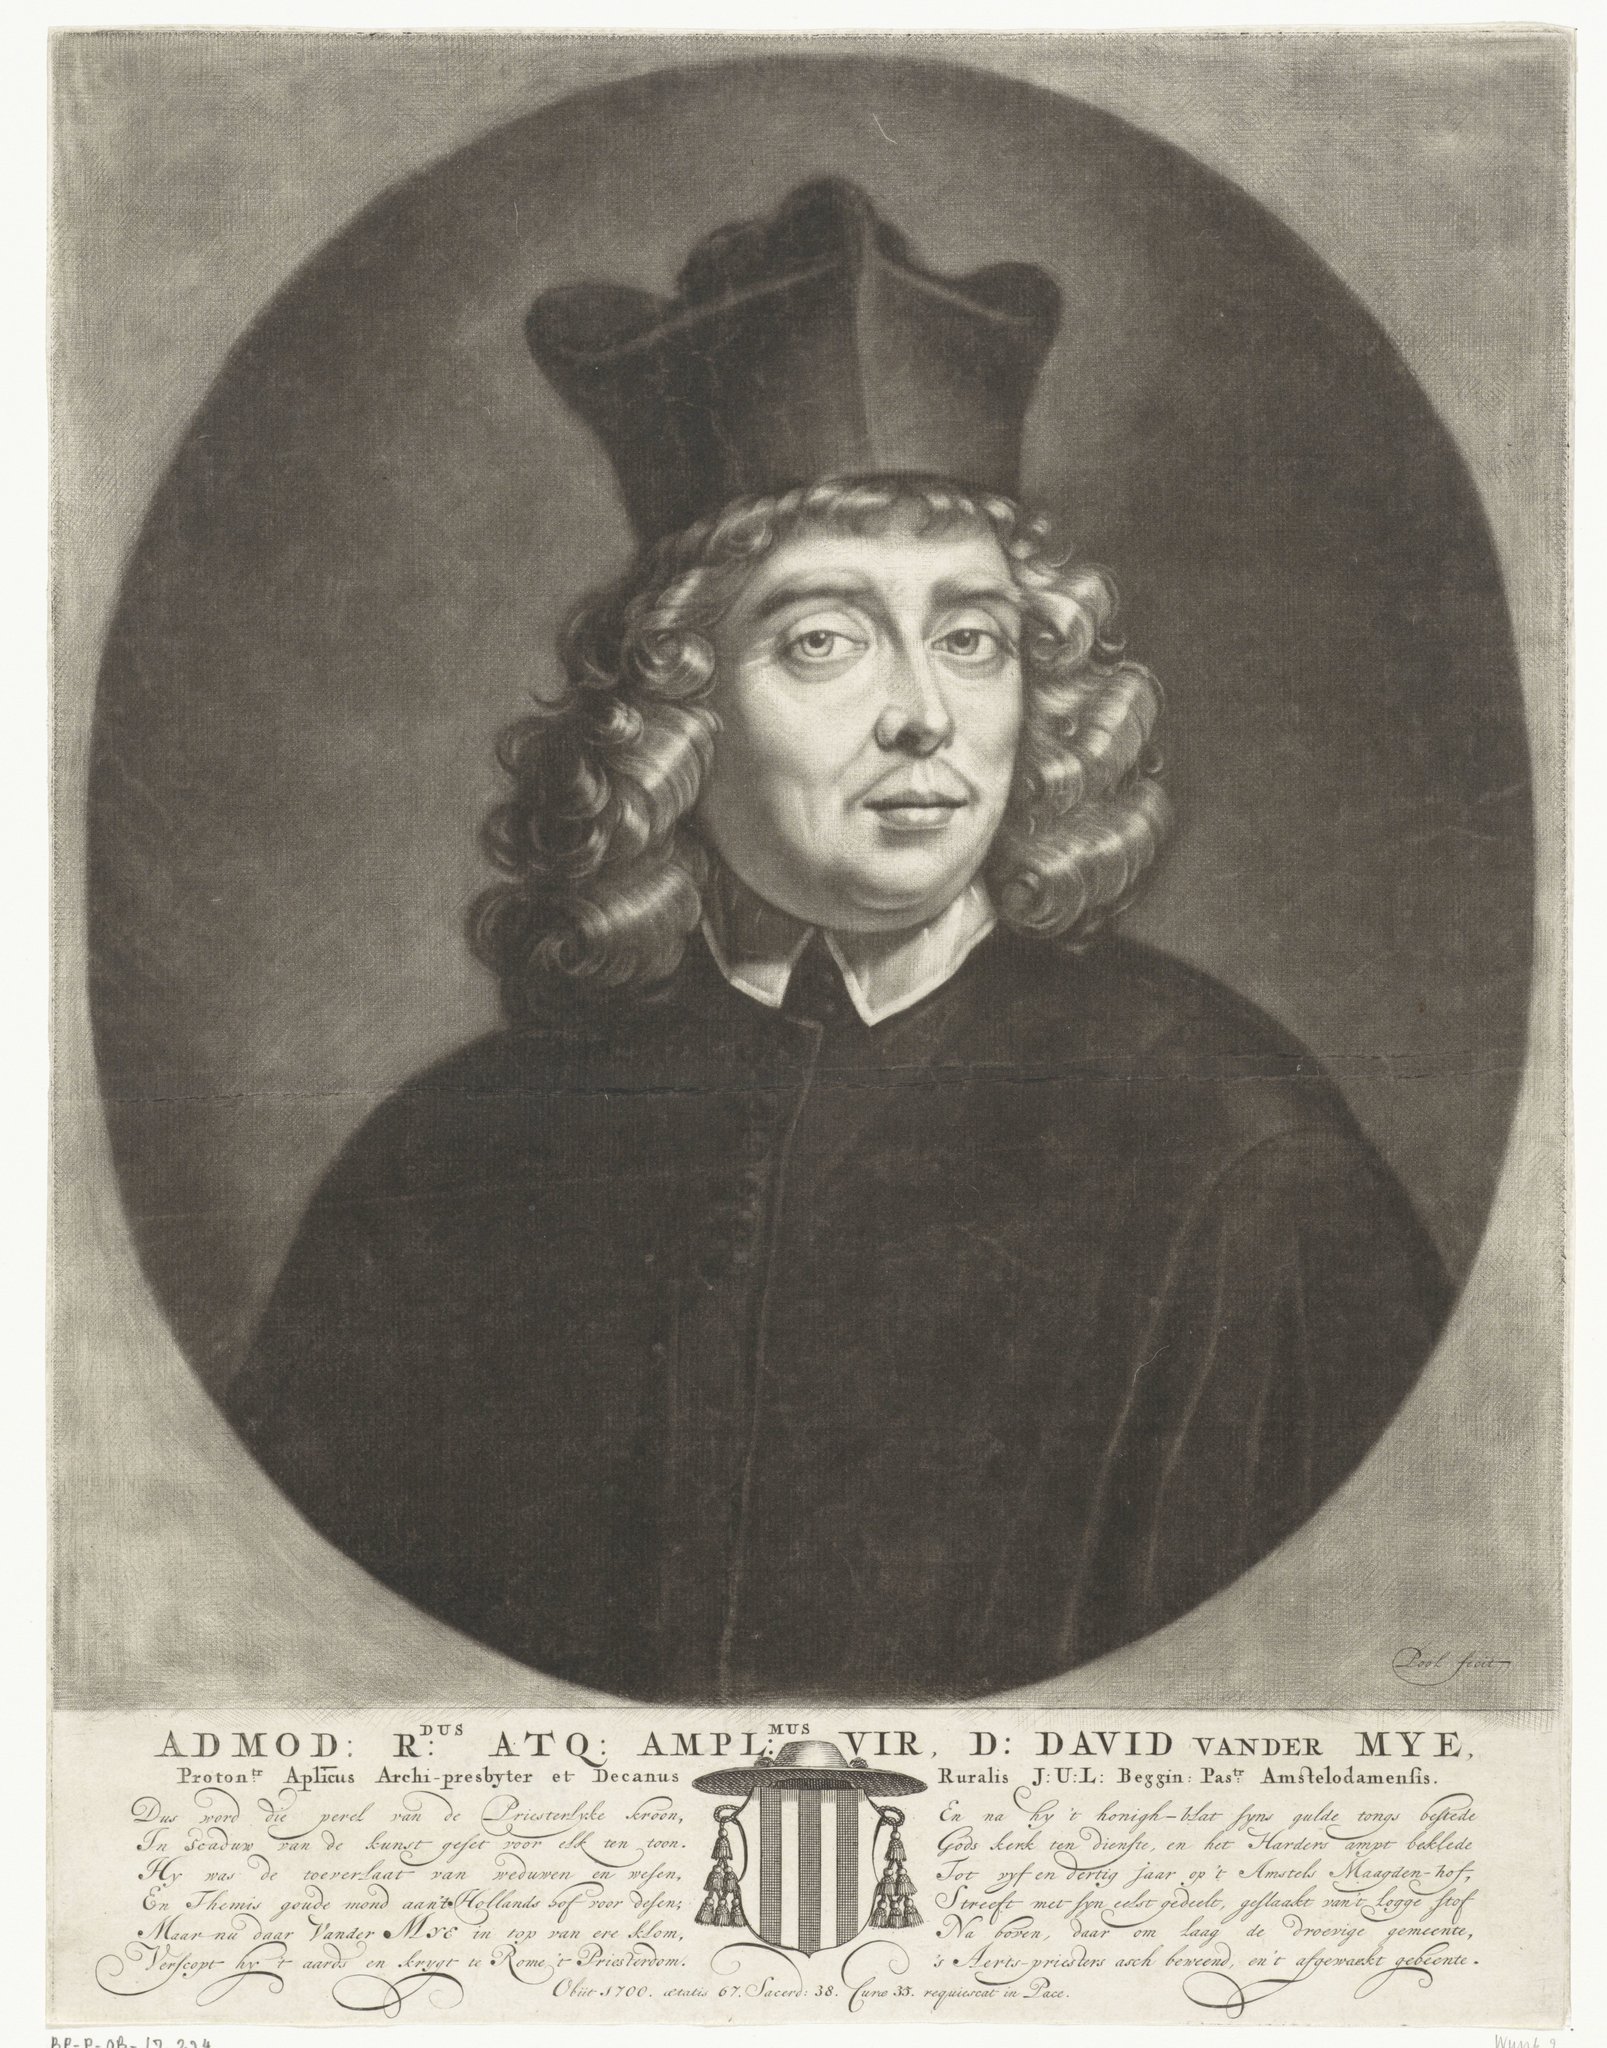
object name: print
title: Portret van David van der Mye, pastoor te Amsterdam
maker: juriaen pool (ii)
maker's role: print maker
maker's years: 1665-1745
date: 1700-1745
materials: paper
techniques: engraving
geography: amsterdam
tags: clergyman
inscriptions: collector's mark: Lugt 2228